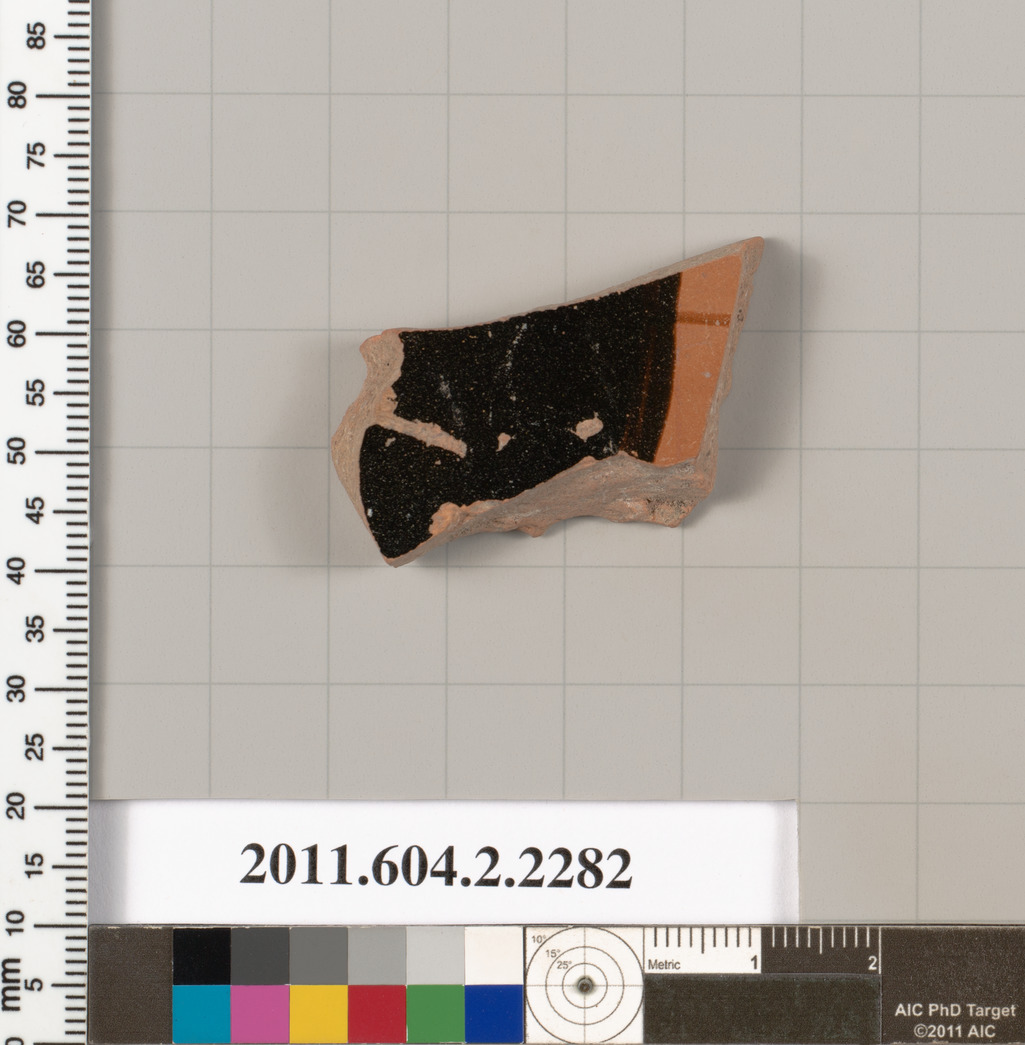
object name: pot fragment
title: Terracotta fragment of a pot; glazed on the inside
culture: greek, attic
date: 460-440 BCE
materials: terracotta